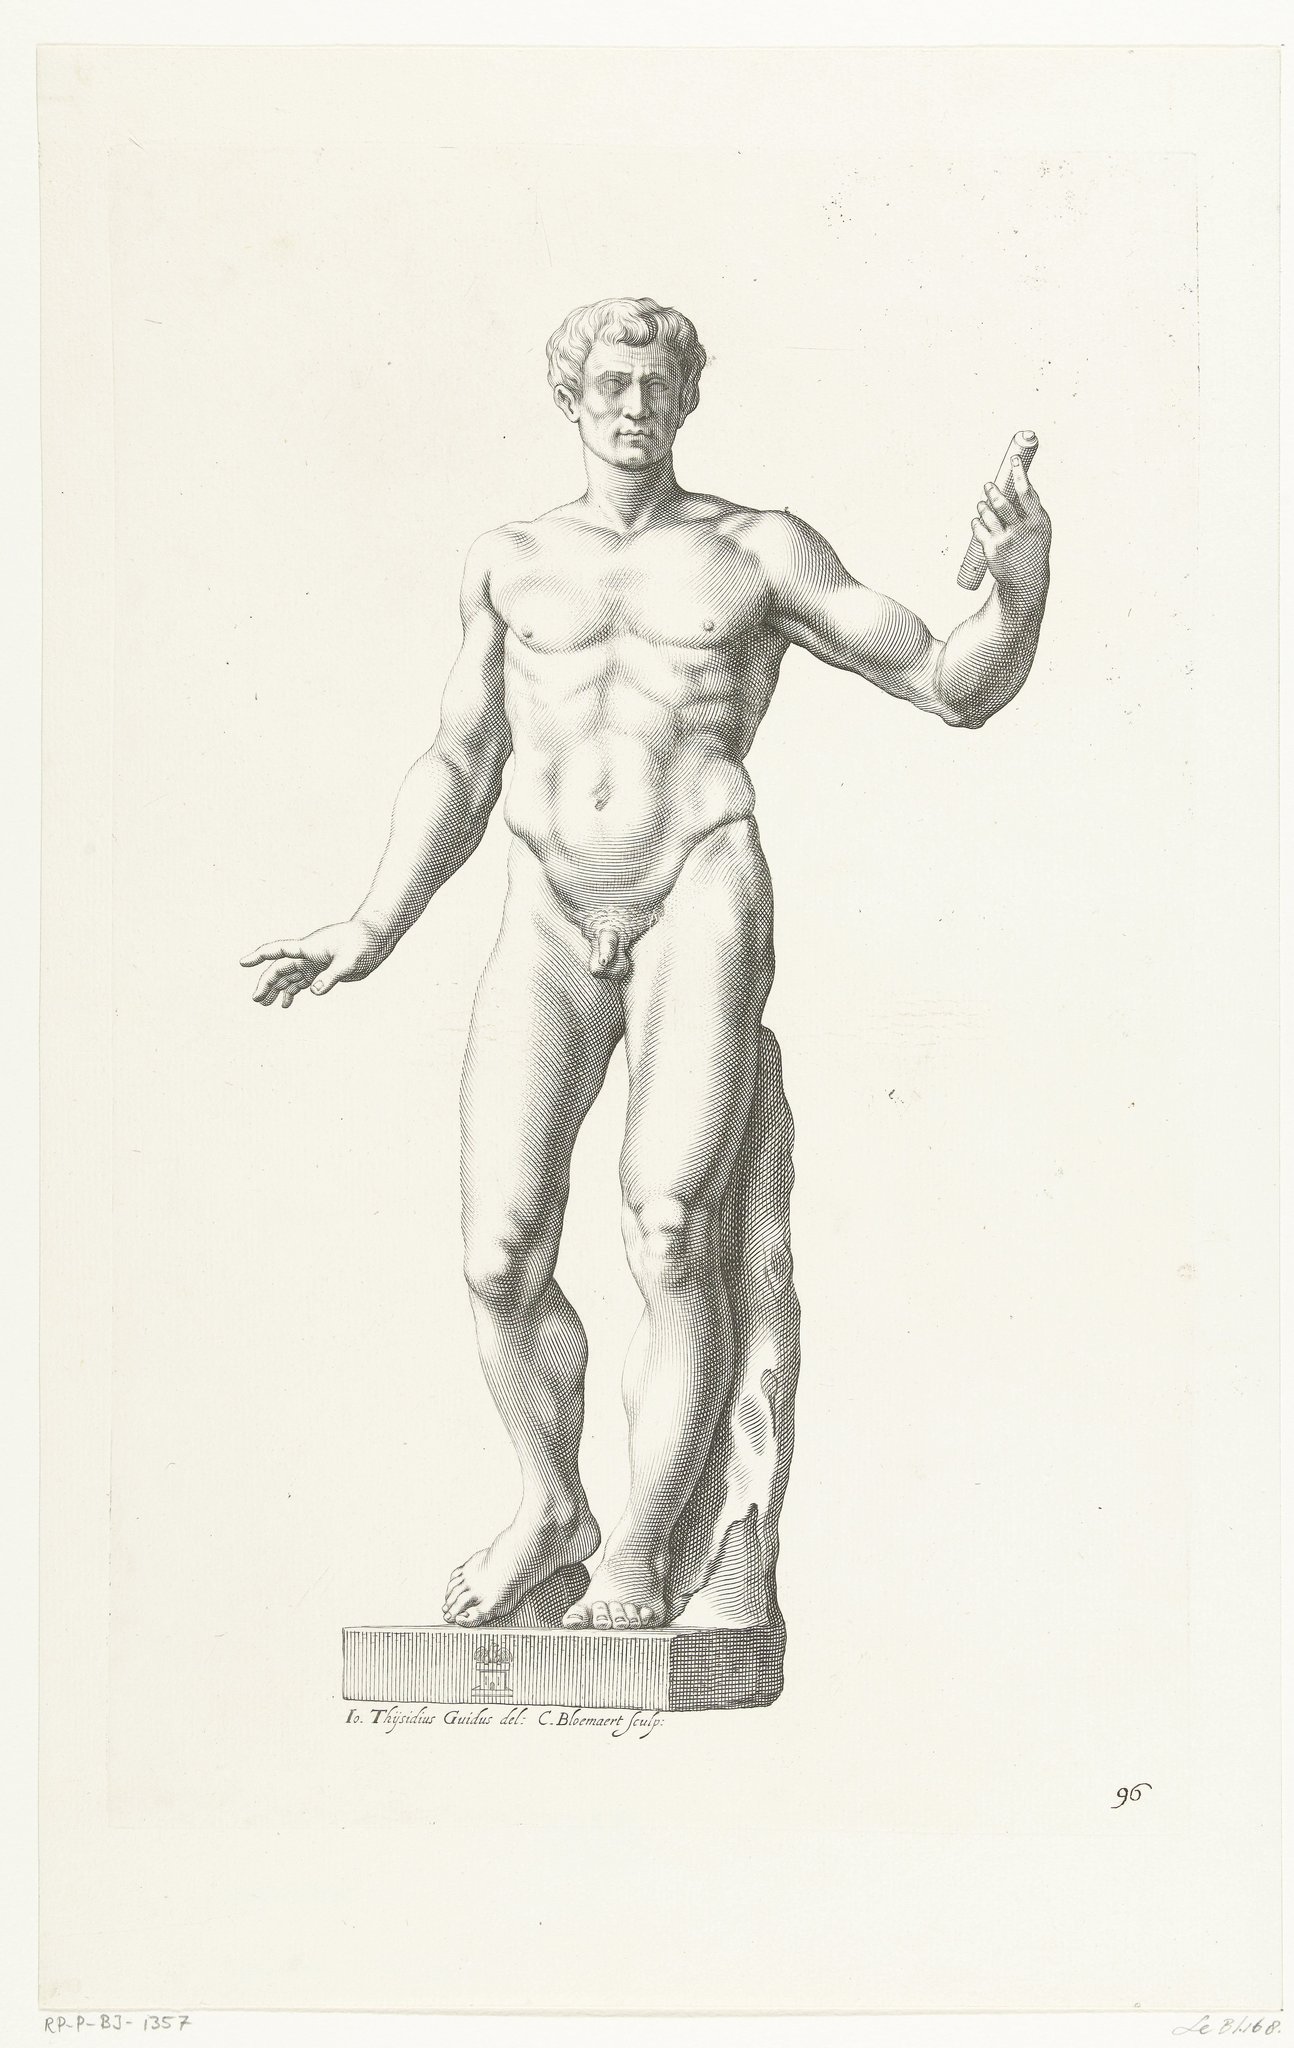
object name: print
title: Caesar Augustus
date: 1636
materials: paper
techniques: engraving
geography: rome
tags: piece of sculpture, reproduction of a piece of sculpture, classical history (+ full length)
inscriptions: number: ‘96’, collector's mark: Lugt 2228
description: Beeld van de keizer Caesar Augustus, naakt met een commandostaf in zijn hand. Het beeld is afkomstig uit de collectie van Vincenzo Giustiniani, wiens wapen op de sokkel te zien is.